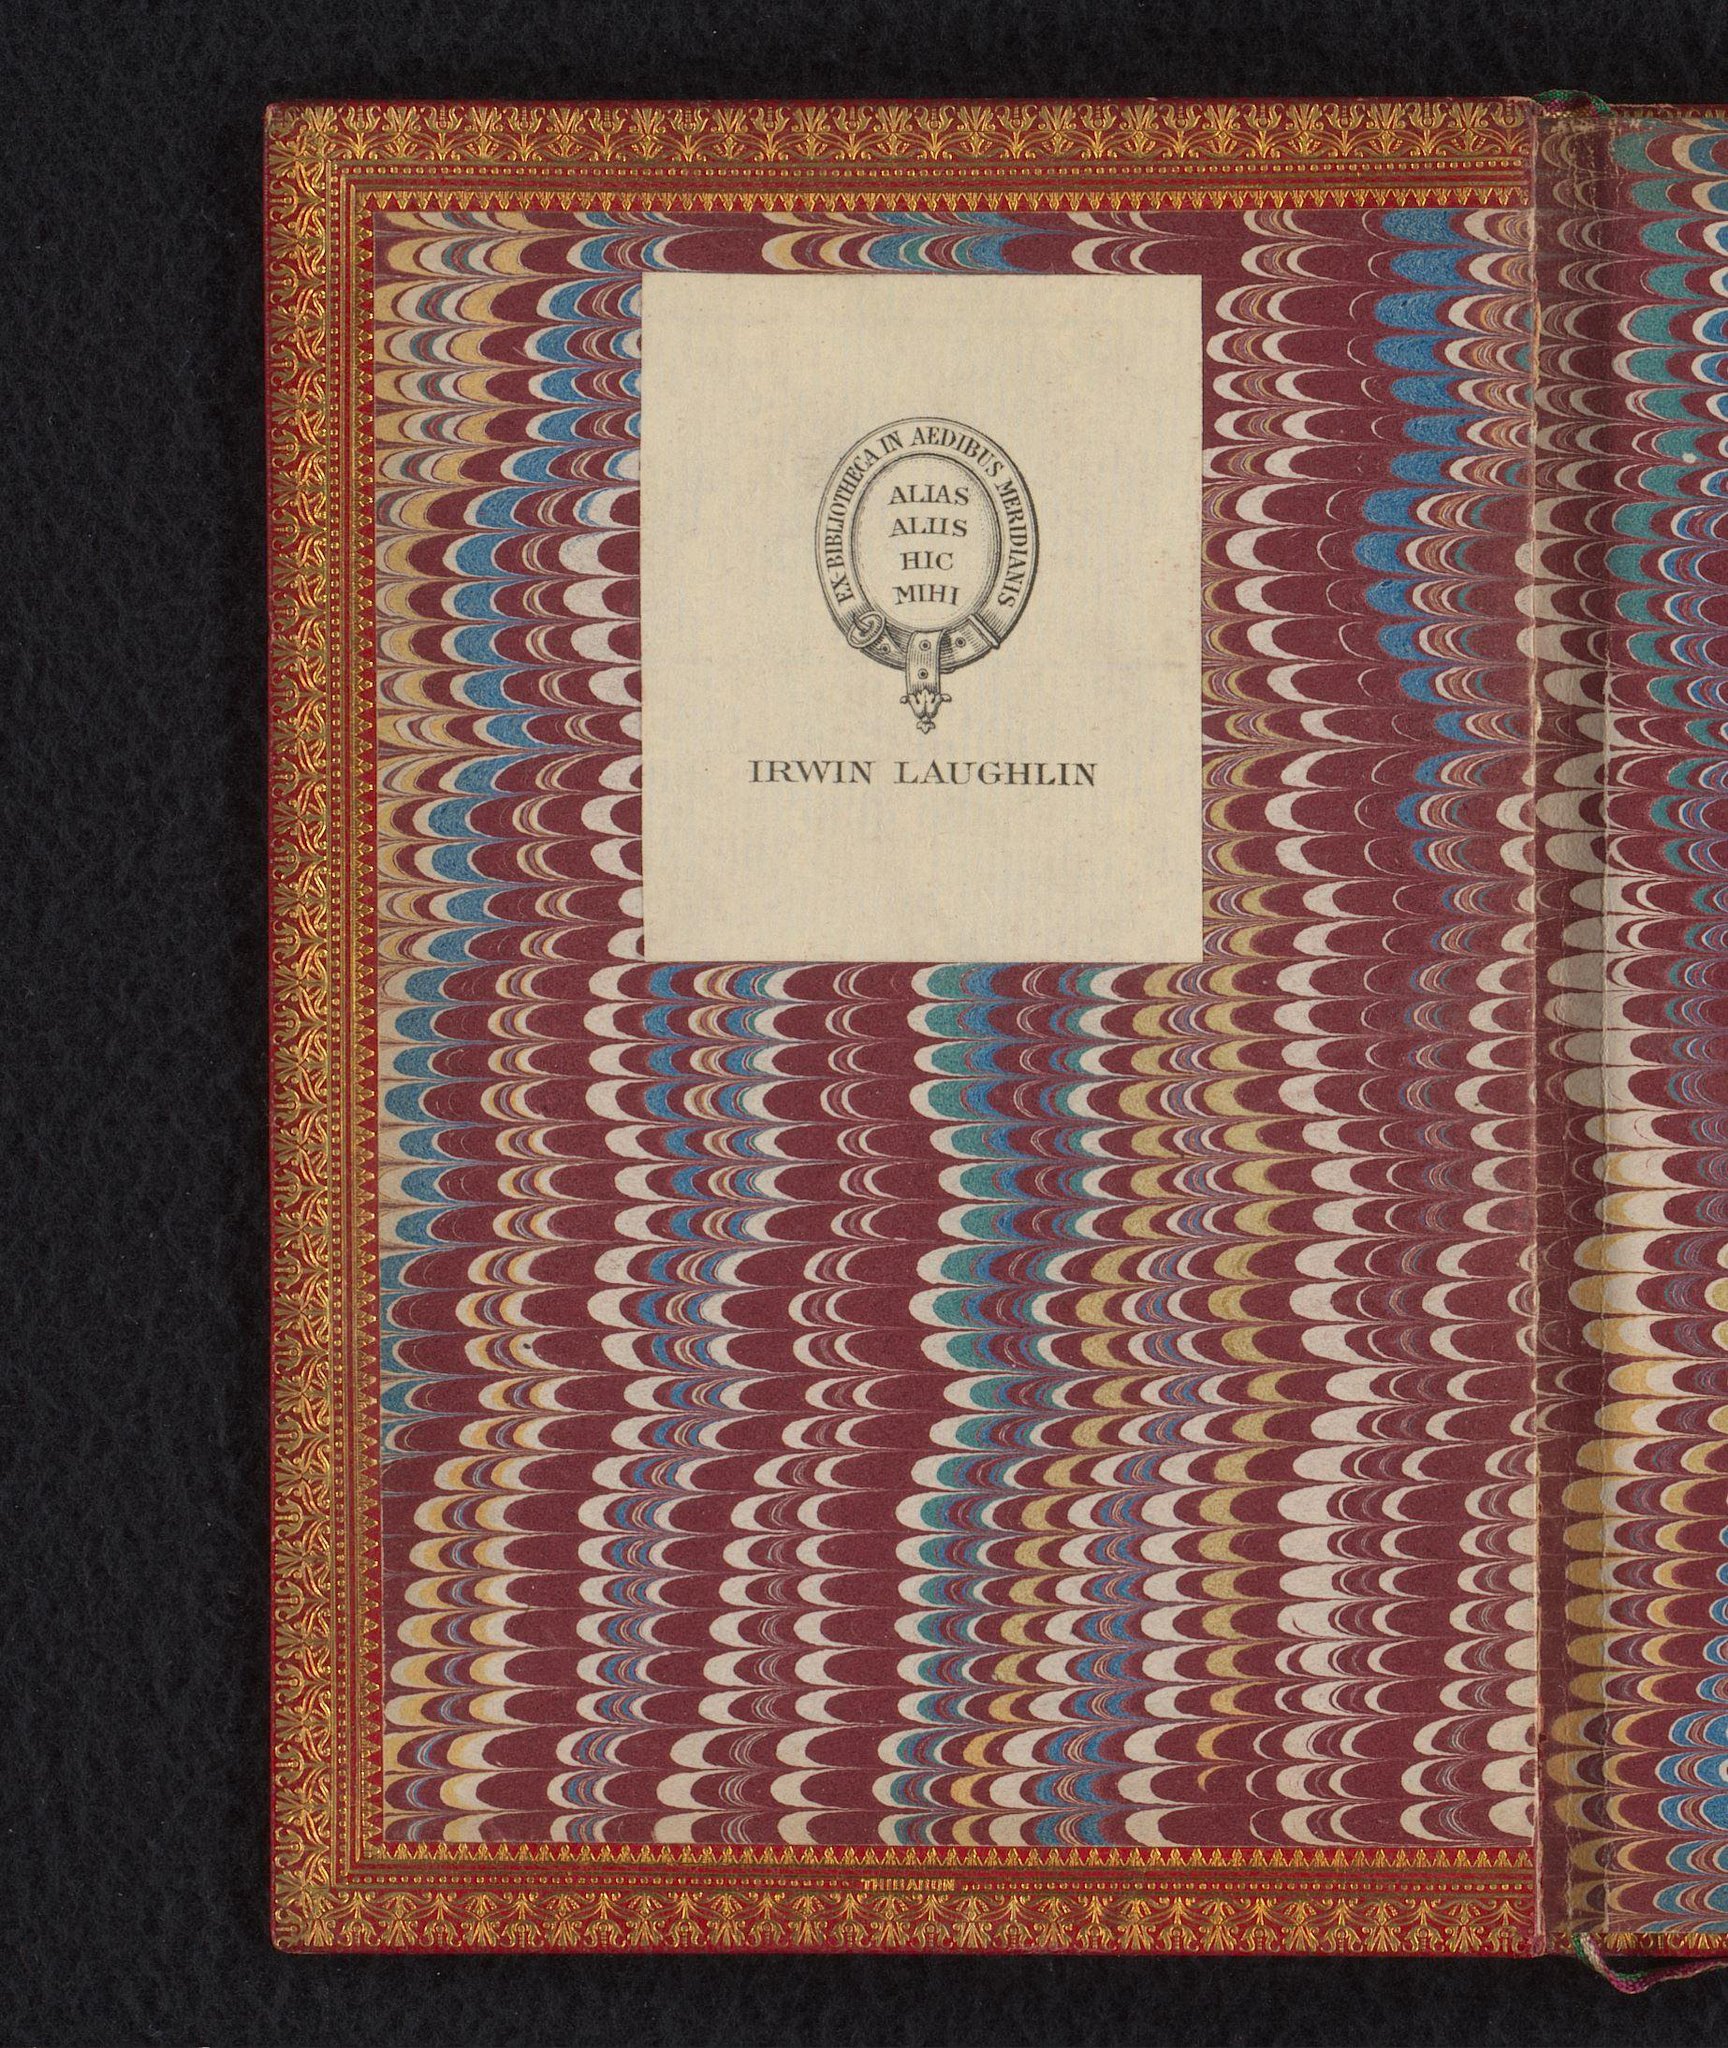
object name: endleaf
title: Ex libris van Irwin Laughlin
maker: Anonymous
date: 1881-1941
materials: paper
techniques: engraving, etching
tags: ex-libris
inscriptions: : ‘Ex-Bibliotheca in Aedibus Meridianis/ Alias/ Aliis/ Hic/ Mihi/ Irwin Laughlin’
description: Cirkelvormige band met onderaan een gesp, met in het midden de woorden 'Alias Aliis Hic Mihi'. Prent maakt deel uit van een album.